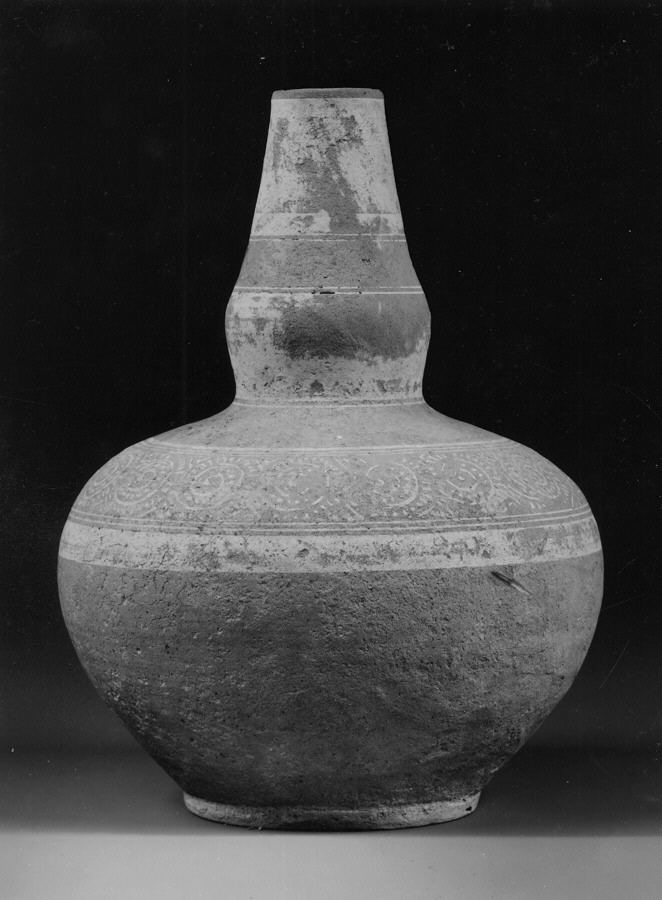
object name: bottle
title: Bottle with Bulbous Neck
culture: thai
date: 1301-1400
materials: terracotta